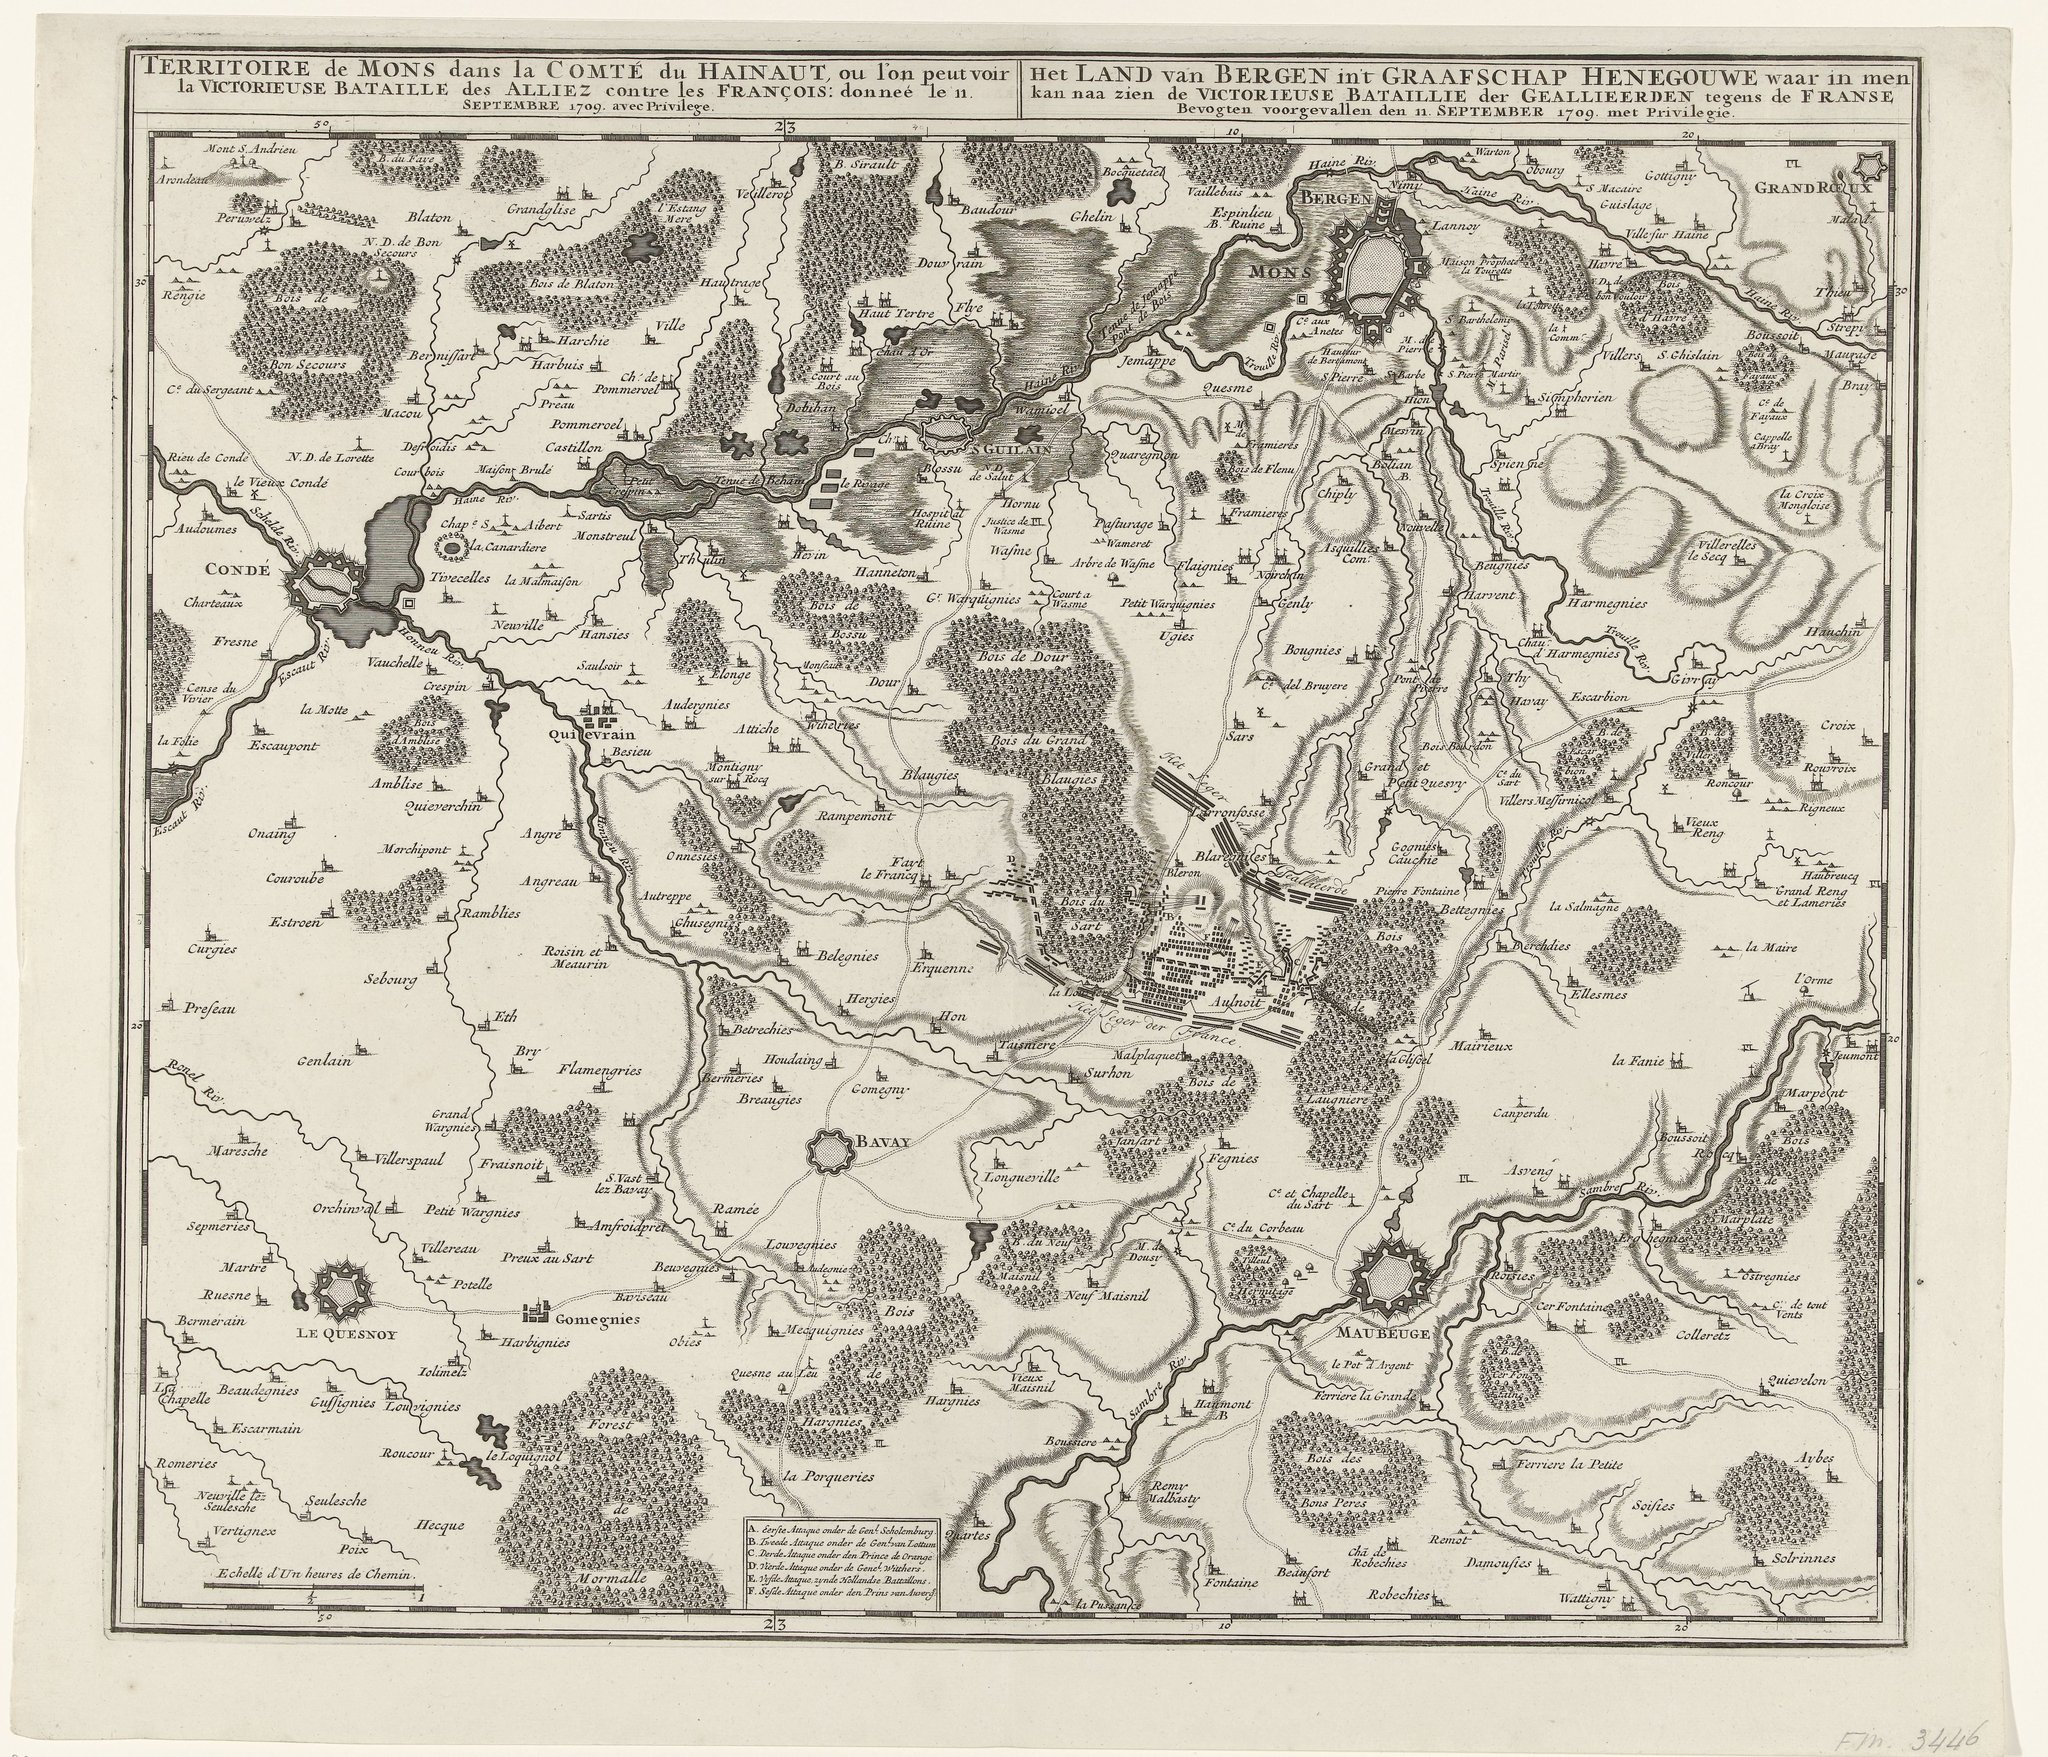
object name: print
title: Kaart met de slag bij Malplaquet, 1709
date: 1709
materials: paper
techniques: etching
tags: maps of separate countries or regions, battle (+ land forces)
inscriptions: collector's mark: Lugt 2228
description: Kaart van de streek in Henegouwen tussen Mons (Bergen), Condé en Maubeuge met de slag bij Malplaquet tussen de Geallieerden onder de hertog van Marlborough en de prins van Savoye en de Fransen, 11 september 1709. Onderaan een cartouche met een lijst van de zes attaques. Linksonder een schaalstok: Echelle d'Un heures de Chemin. De kaart is voorzien van een gradenverdeling langs de randen.